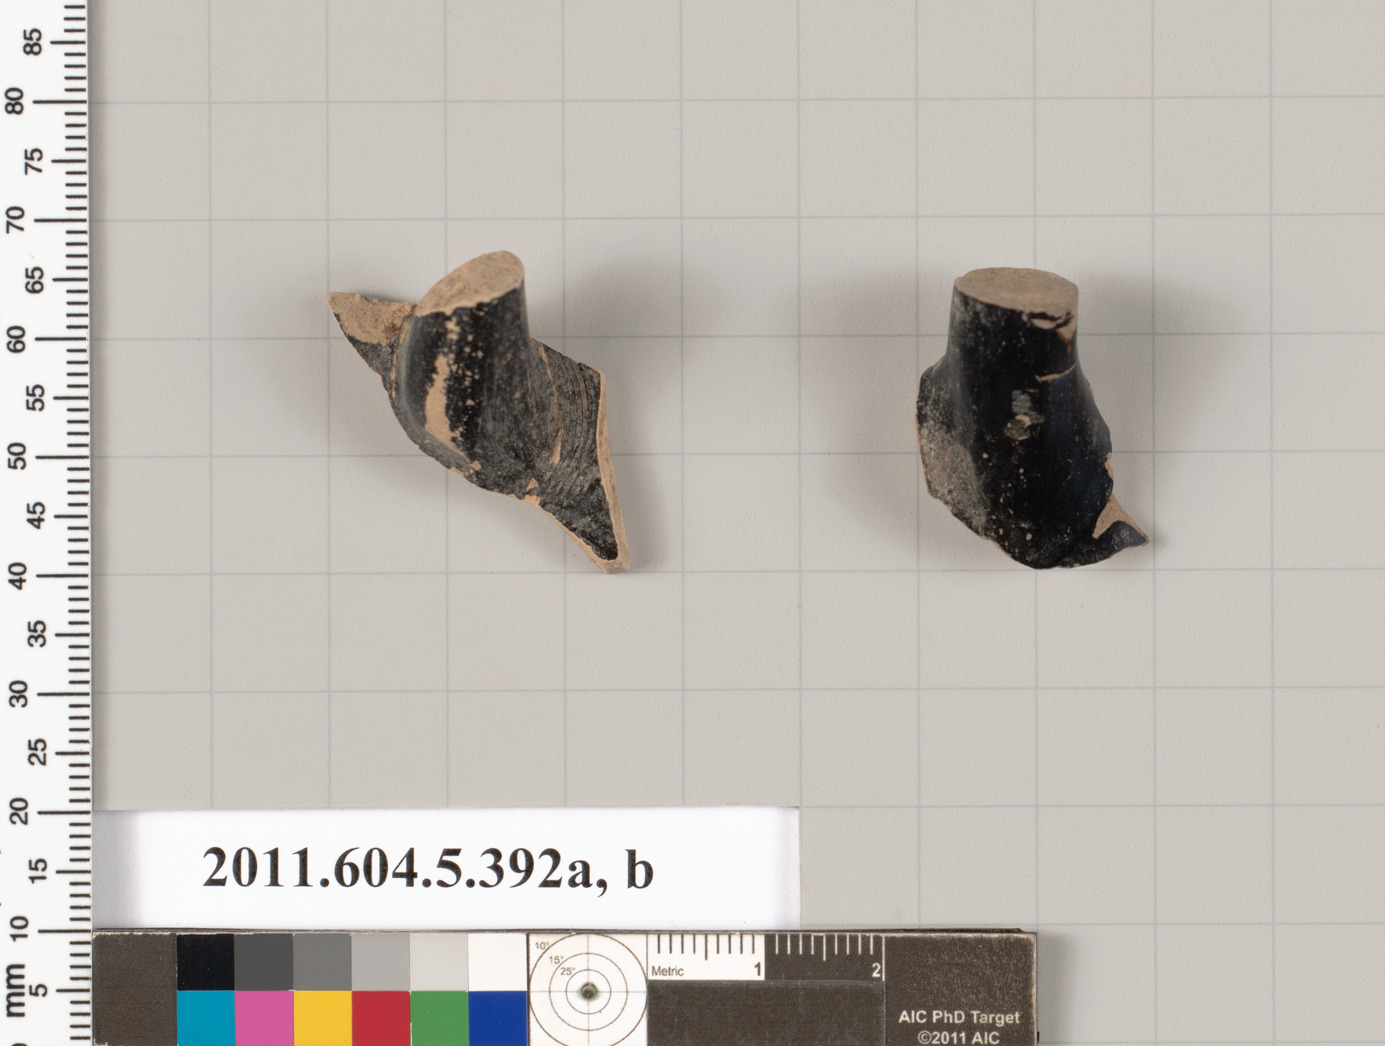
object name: kylix fragment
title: Terracotta fragments of kylikes (drinking cups)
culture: greek, attic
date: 600-401 BCE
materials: terracotta